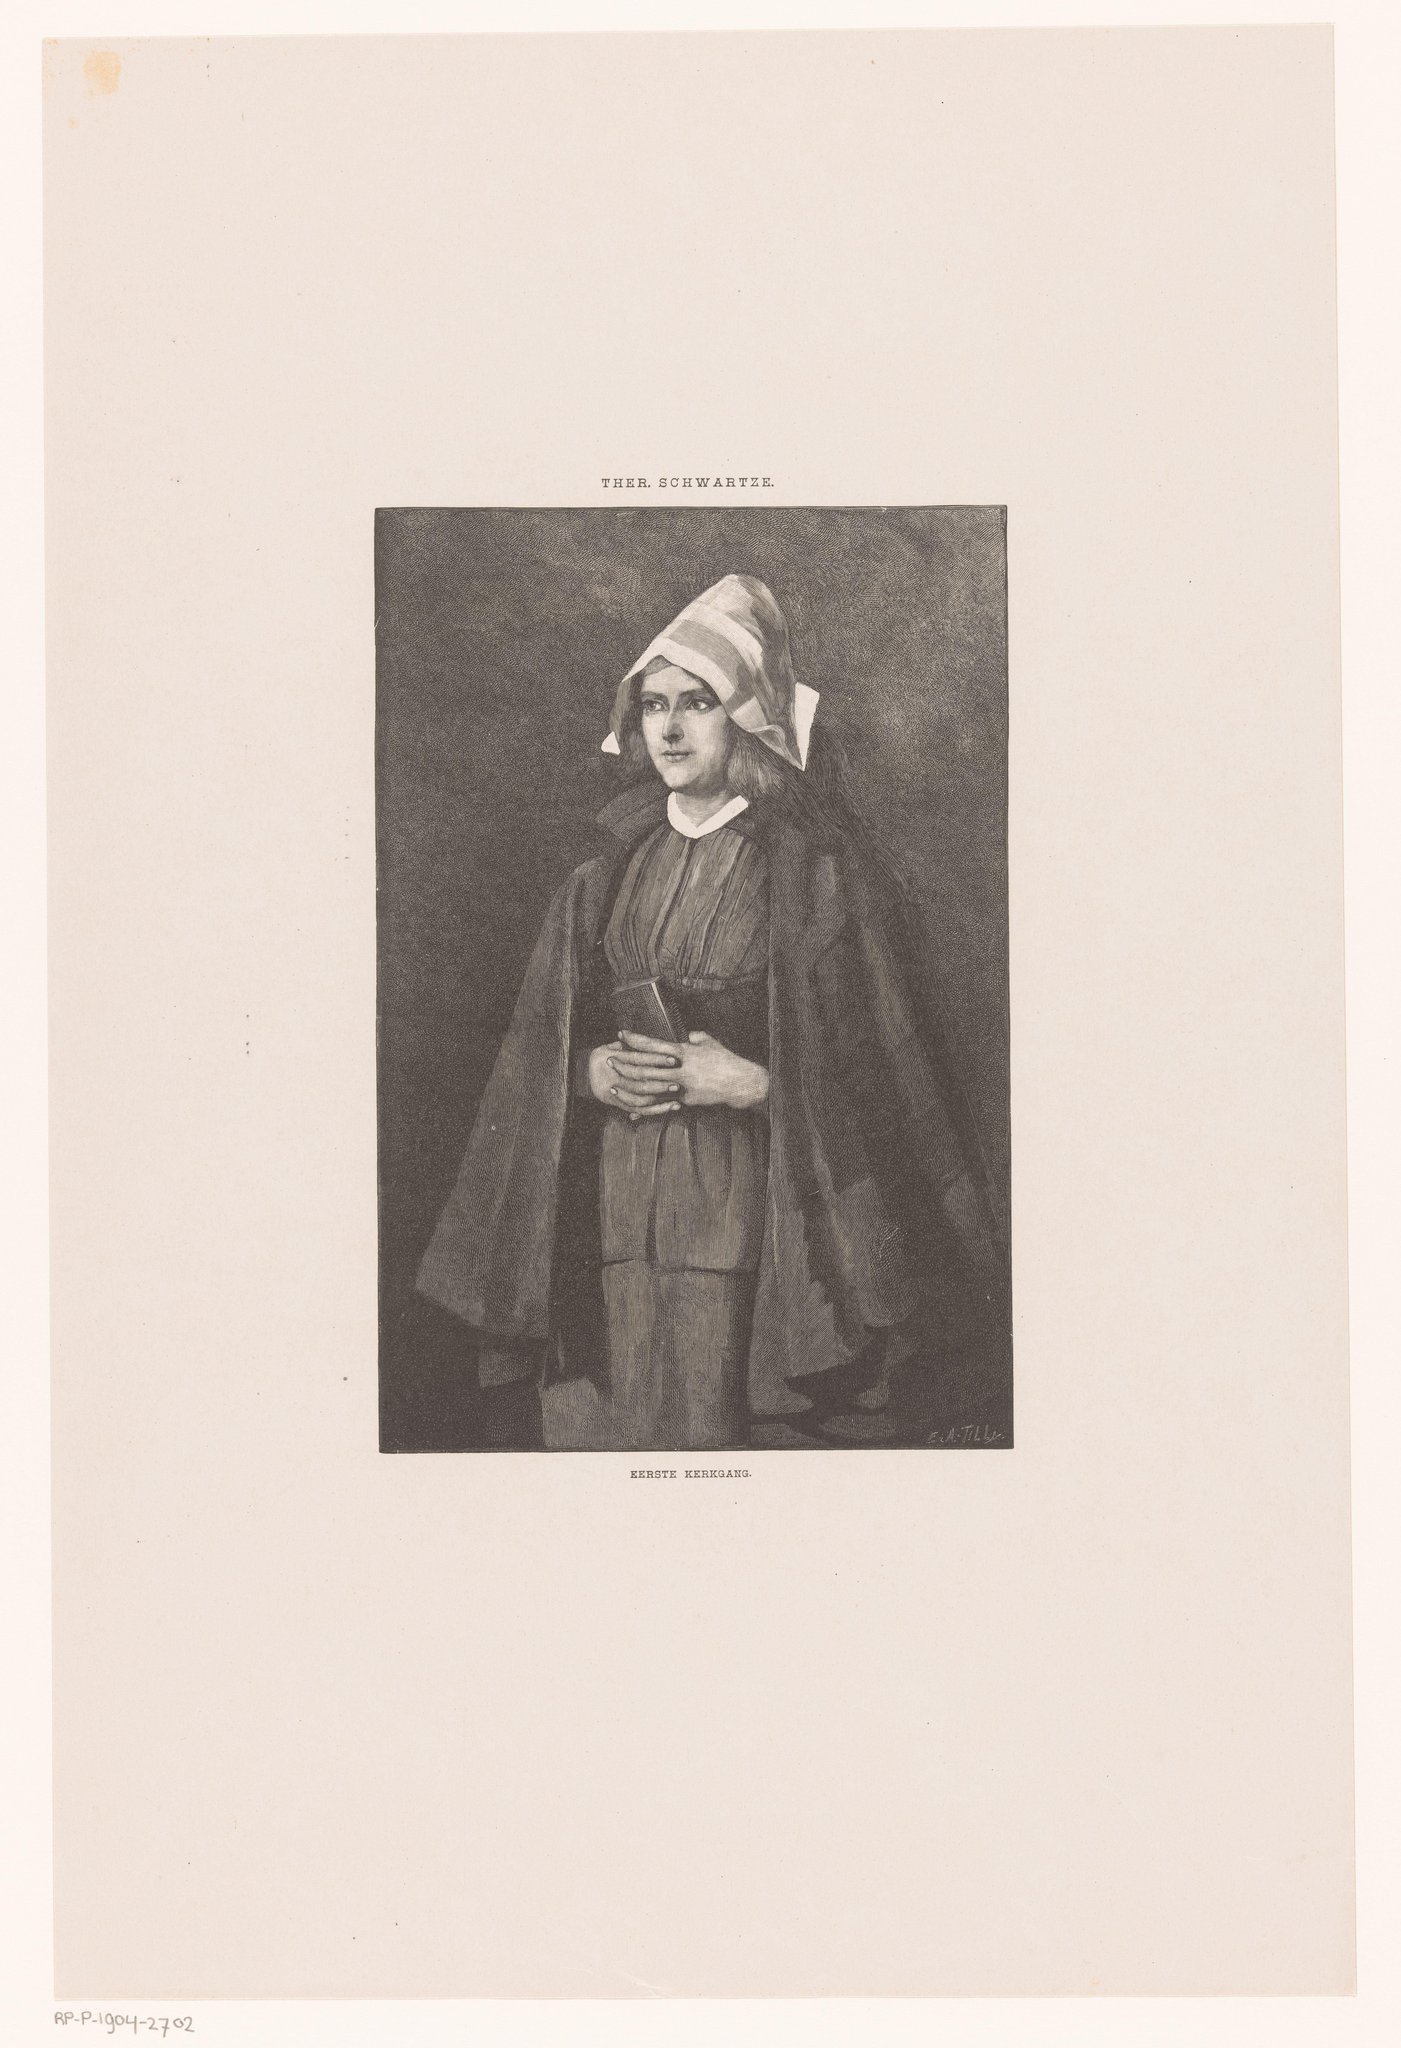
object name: print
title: Jonge vrouw met bijbel in haar handen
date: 1867-1898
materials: paper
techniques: engraving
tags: adult woman, the bible as a book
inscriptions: collector's mark: Lugt 2228